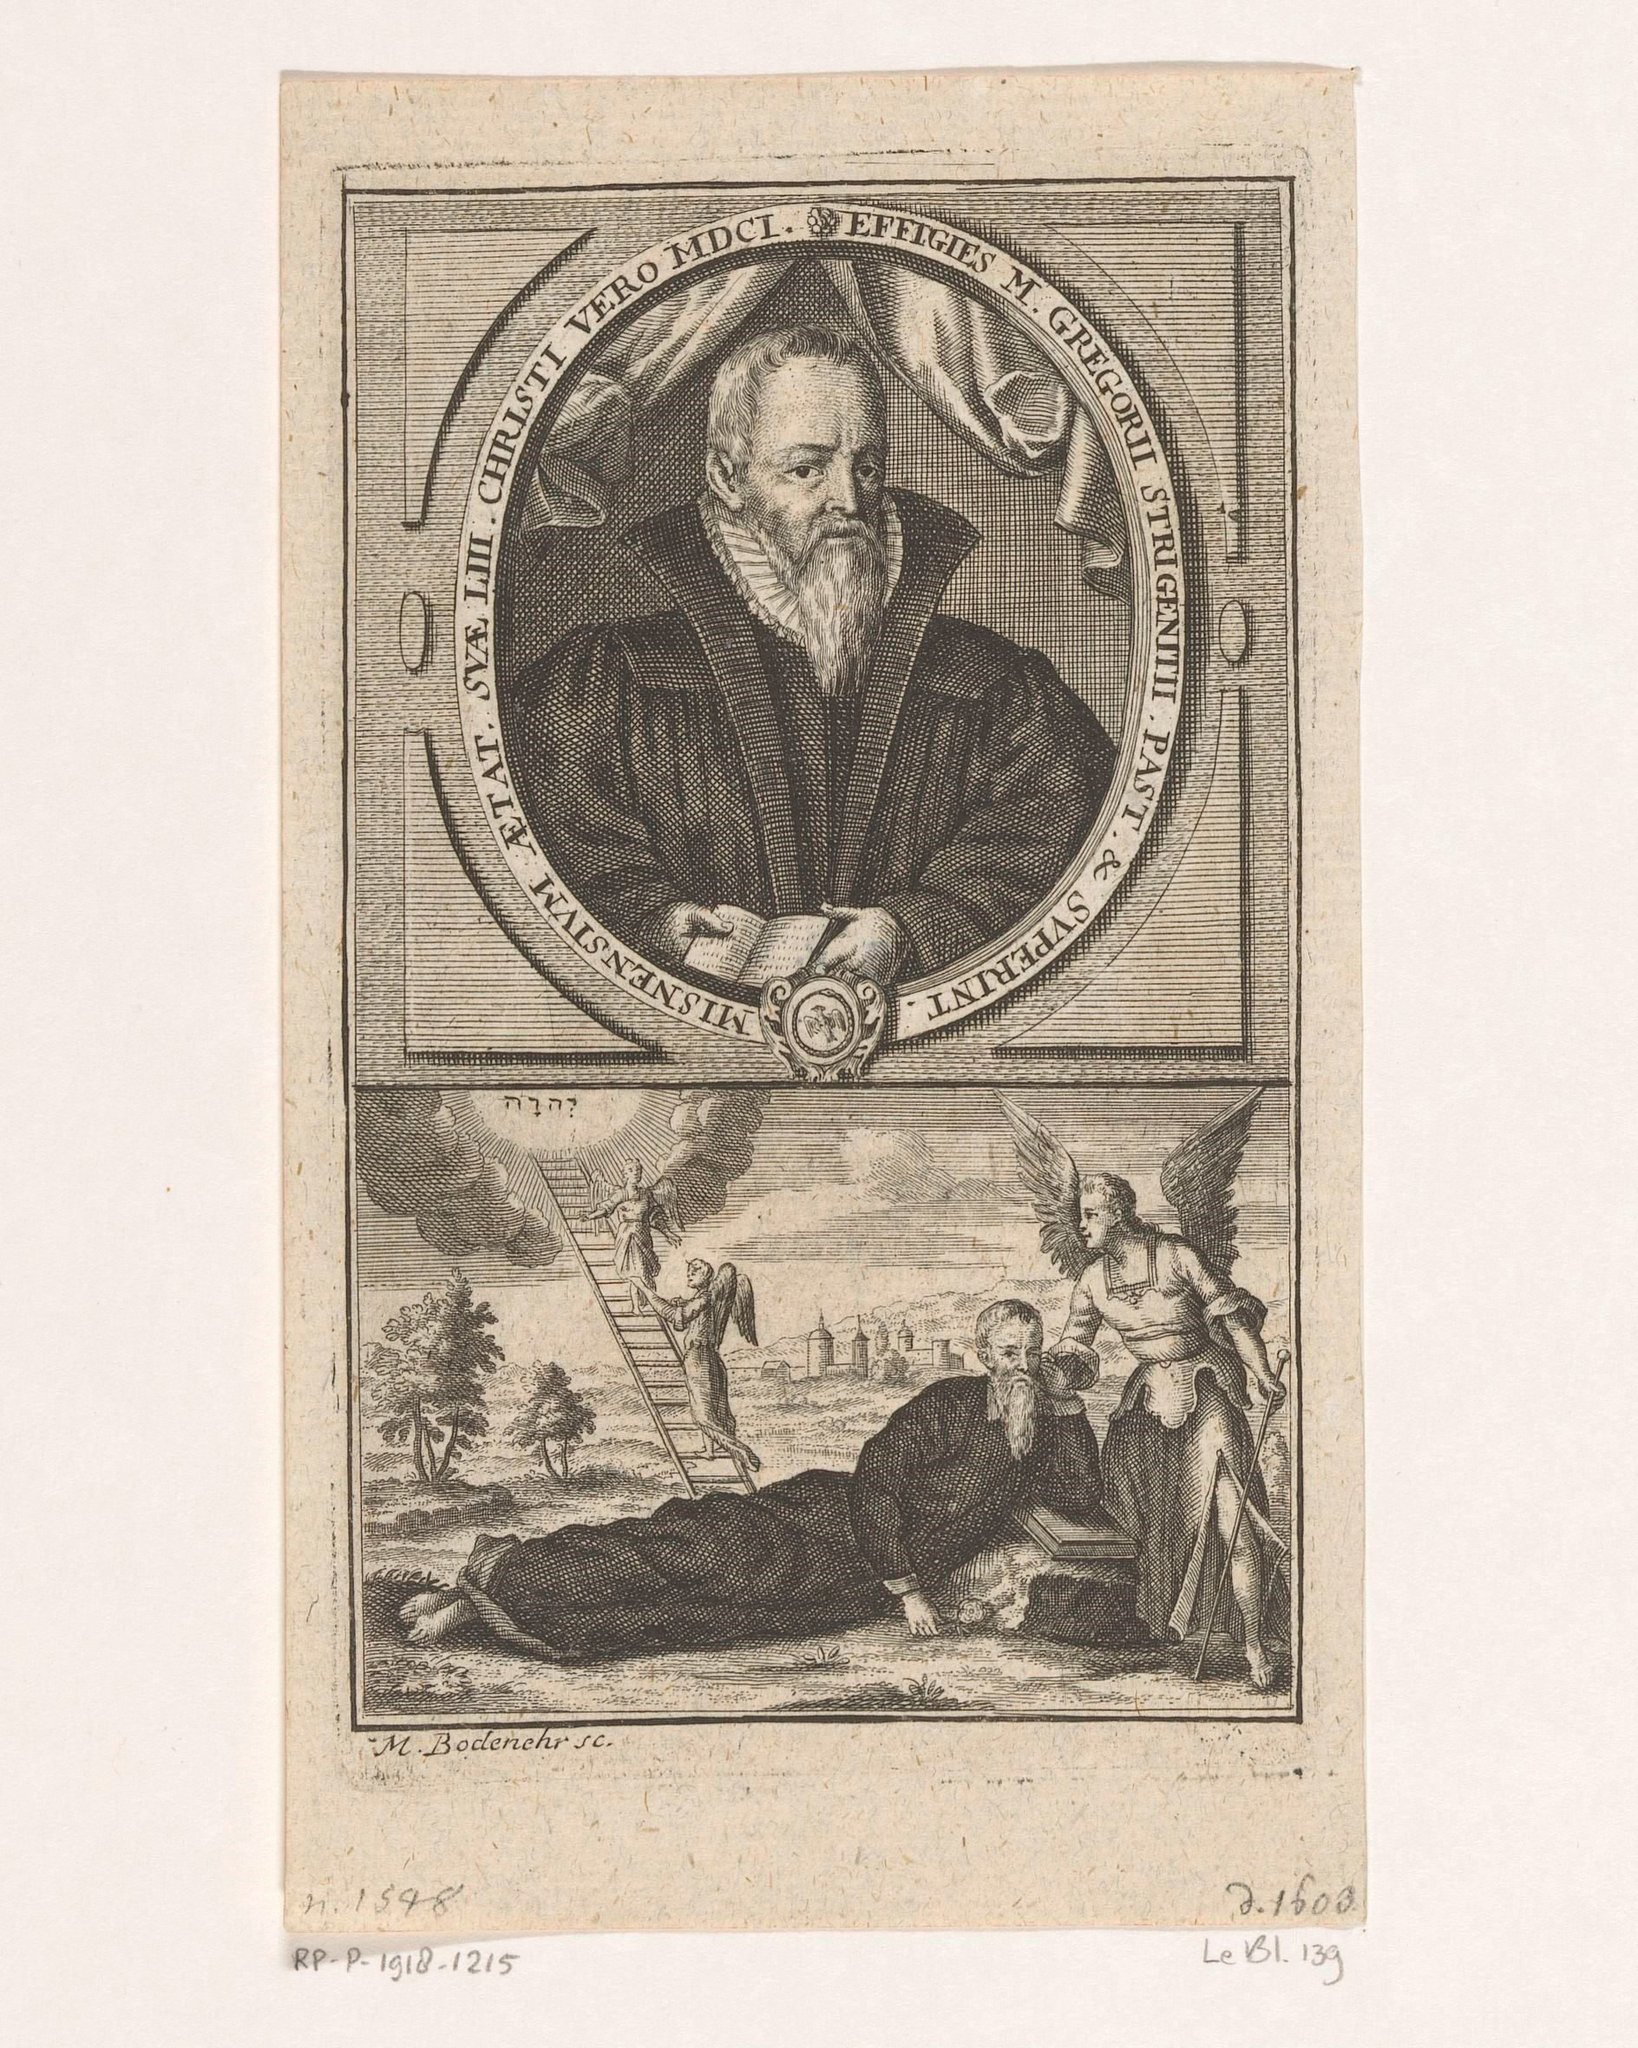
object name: print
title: Portret van Gregor Strigenitz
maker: moritz bodenehr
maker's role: print maker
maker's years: 1665-1749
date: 1675-1748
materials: paper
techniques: engraving, etching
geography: dresden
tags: the archangel michael (often in armour with sword or lance), historical persons, book - mm - book open, tetragram (in roman or hebrew script) ~ symbol of god the father, ladder, stairway to heaven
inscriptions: collector's mark: Lugt 2233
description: Onder het portret een landschap met Strigenitz liggend op de grond, zijn rechterarm leunend op een boek op een rots. Naast hem staat aartsengel Michaël. In de achtergrond een ladder naar de hemel.